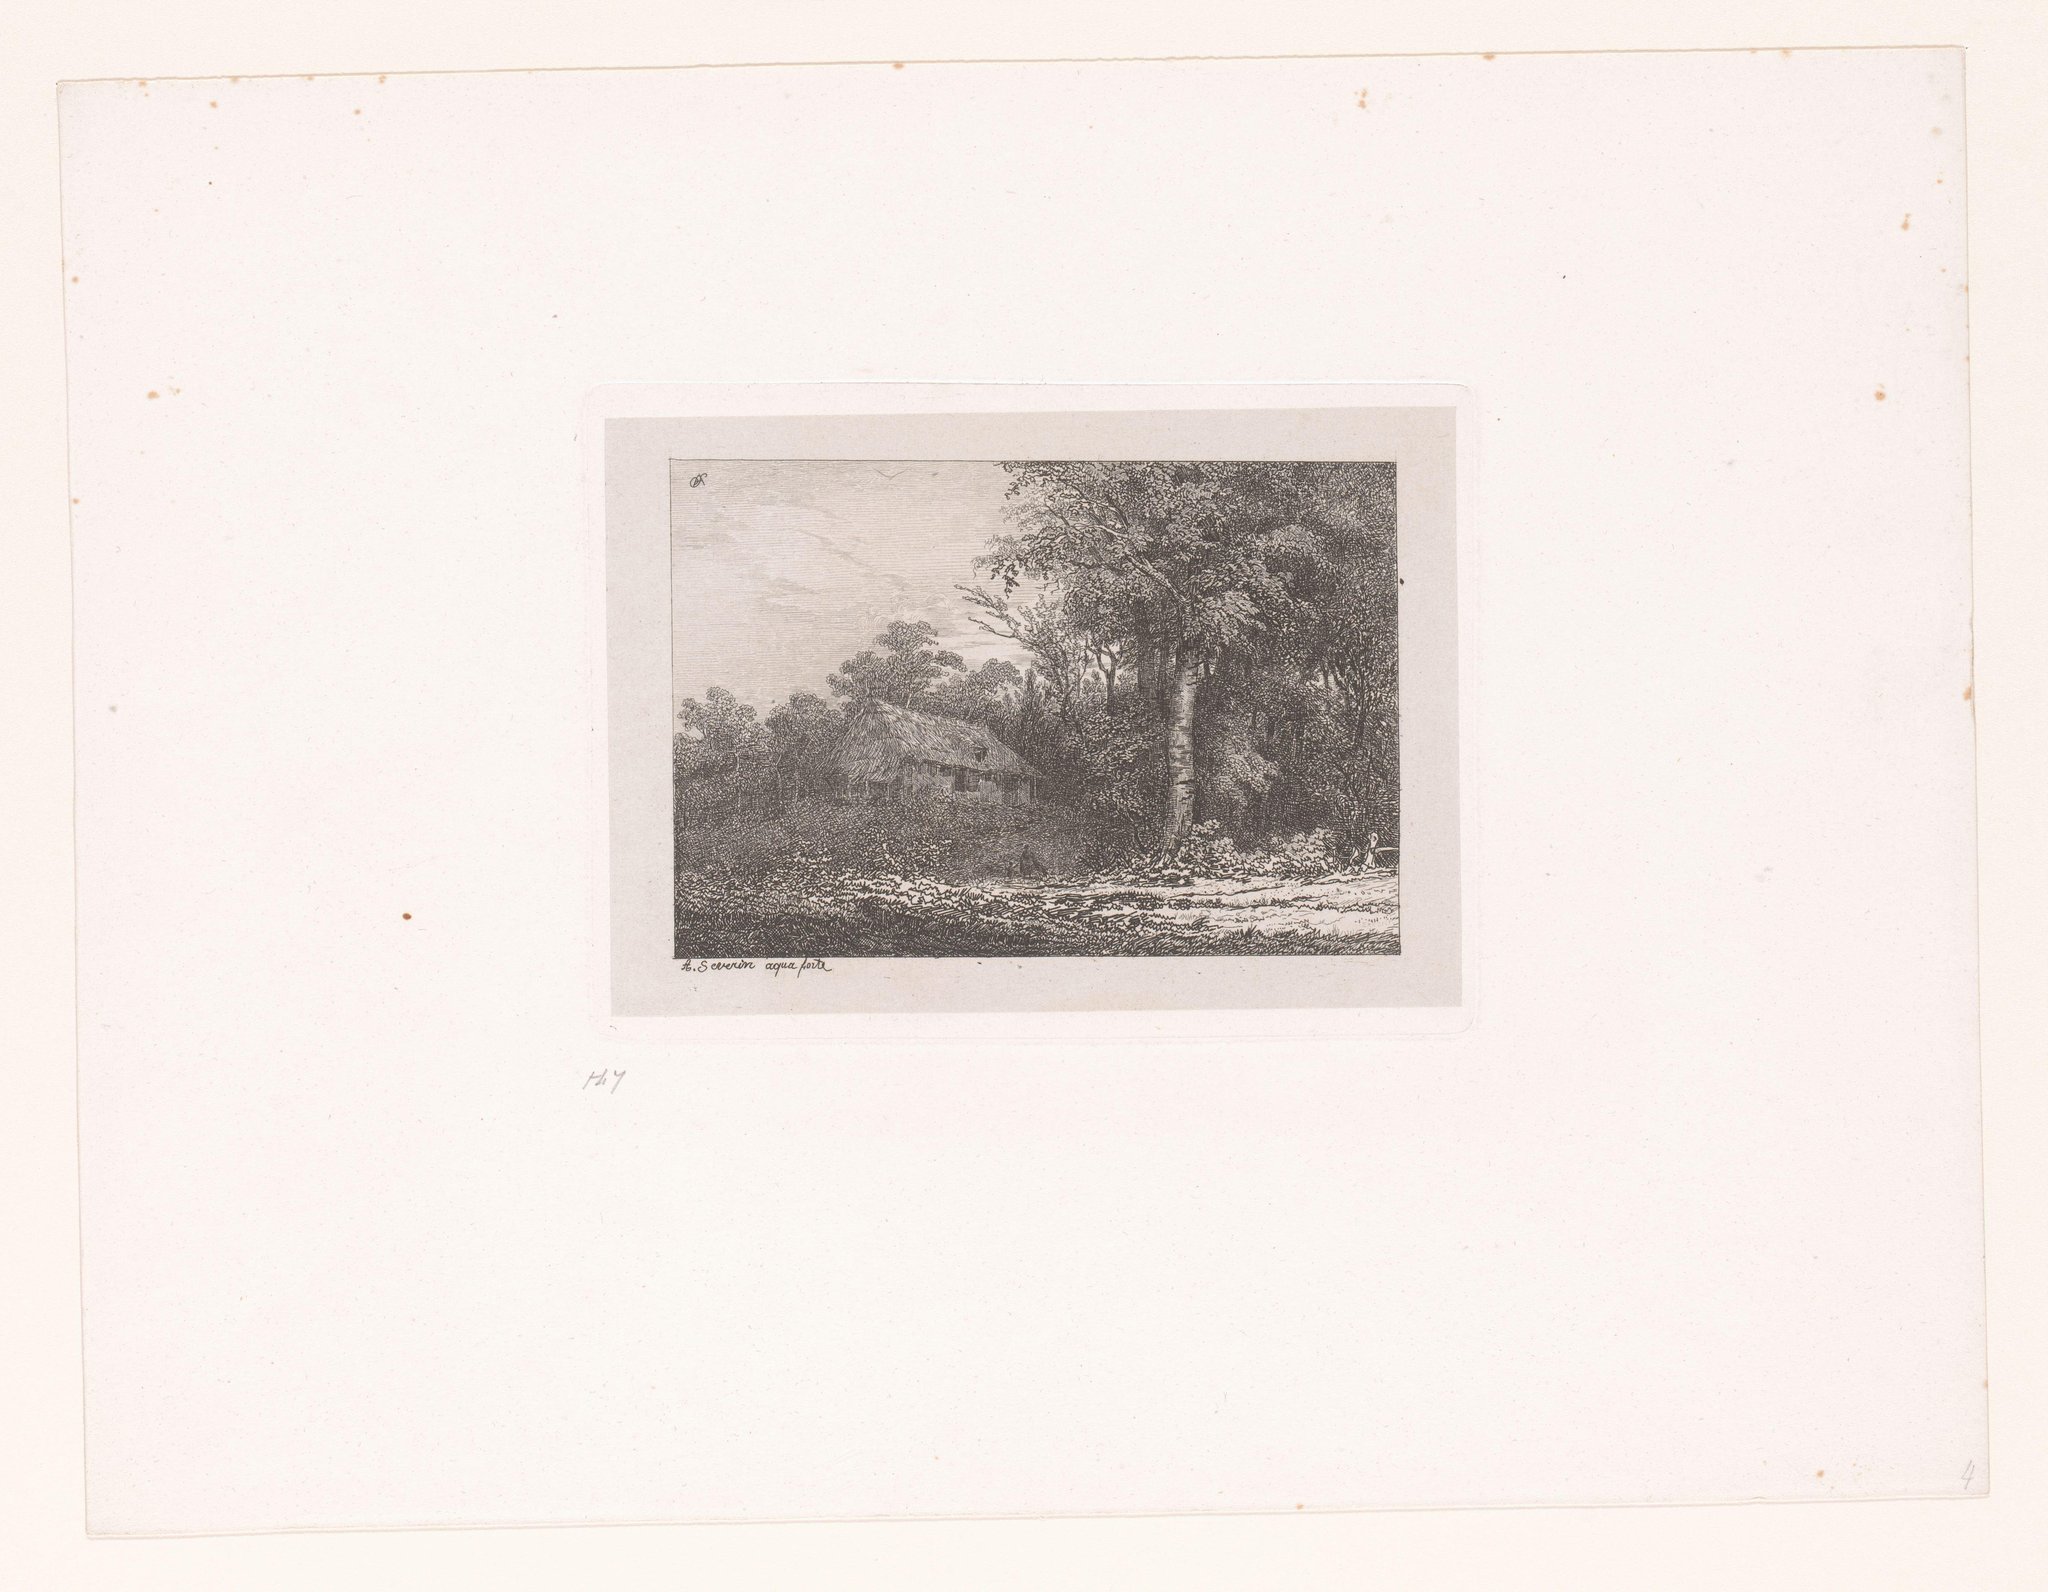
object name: print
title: Negen landschappen door Antoine Severin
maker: antoine severin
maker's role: print maker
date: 1851-1852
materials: paper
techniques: etching, intaglio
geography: brussels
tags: fringe, edge of the wood, hut, cabin, lodge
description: Prent maakt deel uit van een serie van negen prenten.